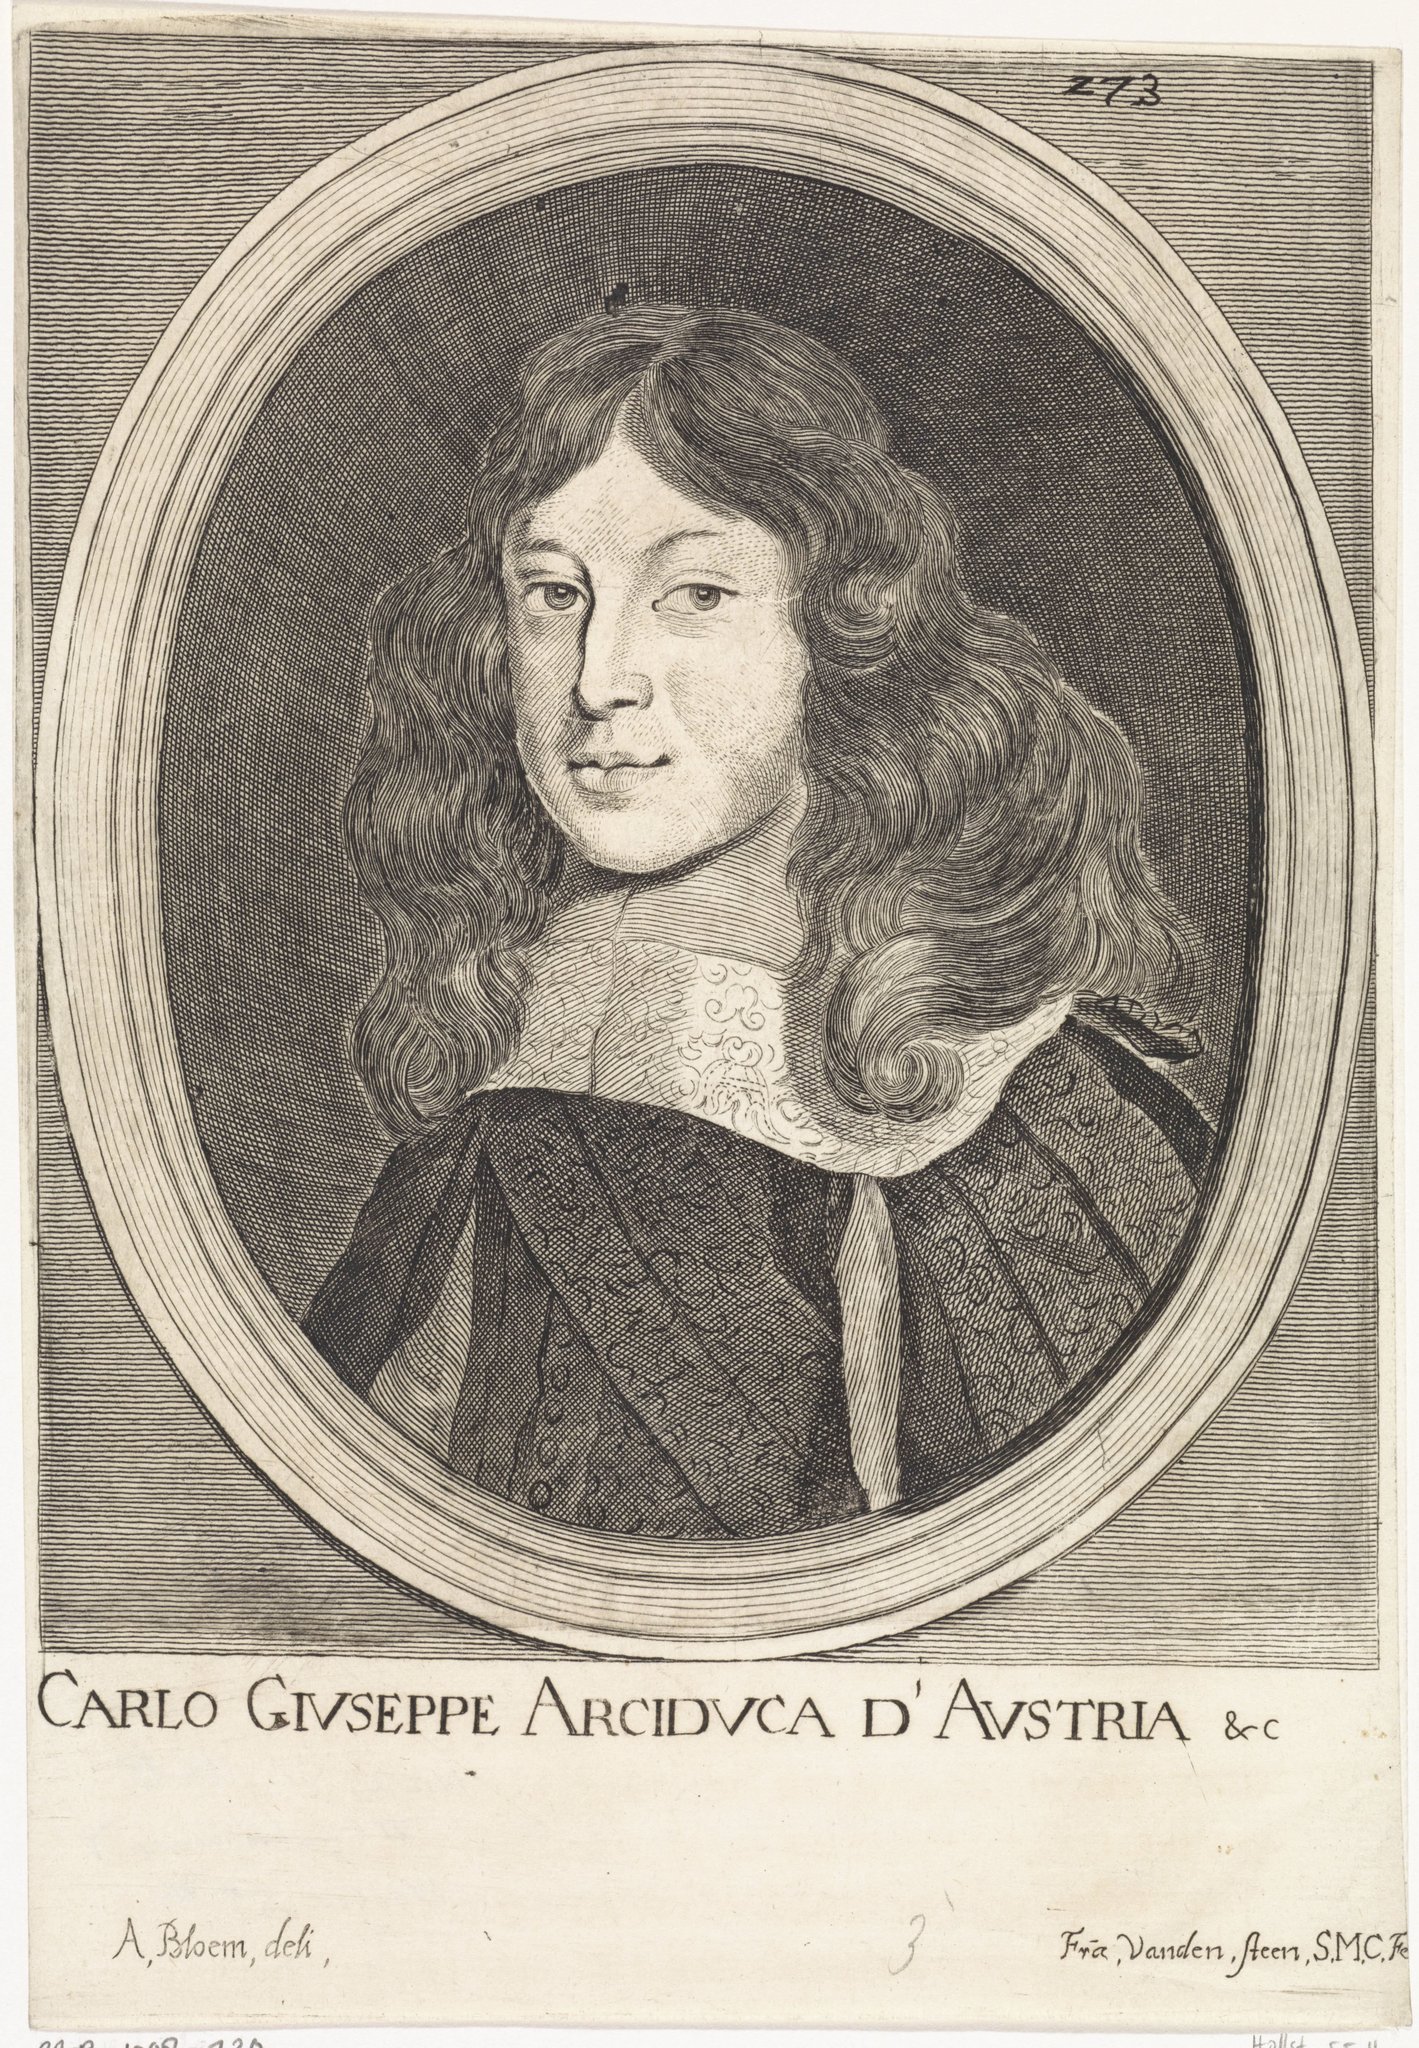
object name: print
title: Portret van aartshertog Karel Jozef van Oostenrijk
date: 1670-1674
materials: paper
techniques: engraving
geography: vienna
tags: linz, bisschop, karel jozef van oostenrijk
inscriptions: collector's mark: Lugt 2228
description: Prent mogelijk gebruikt in: Gualdo Priorato, Galeazzo. Historia di Leopoldo Cesare, (...). 3 dln. Wenen, Giovanni Battista Hacque, 1670-1674.